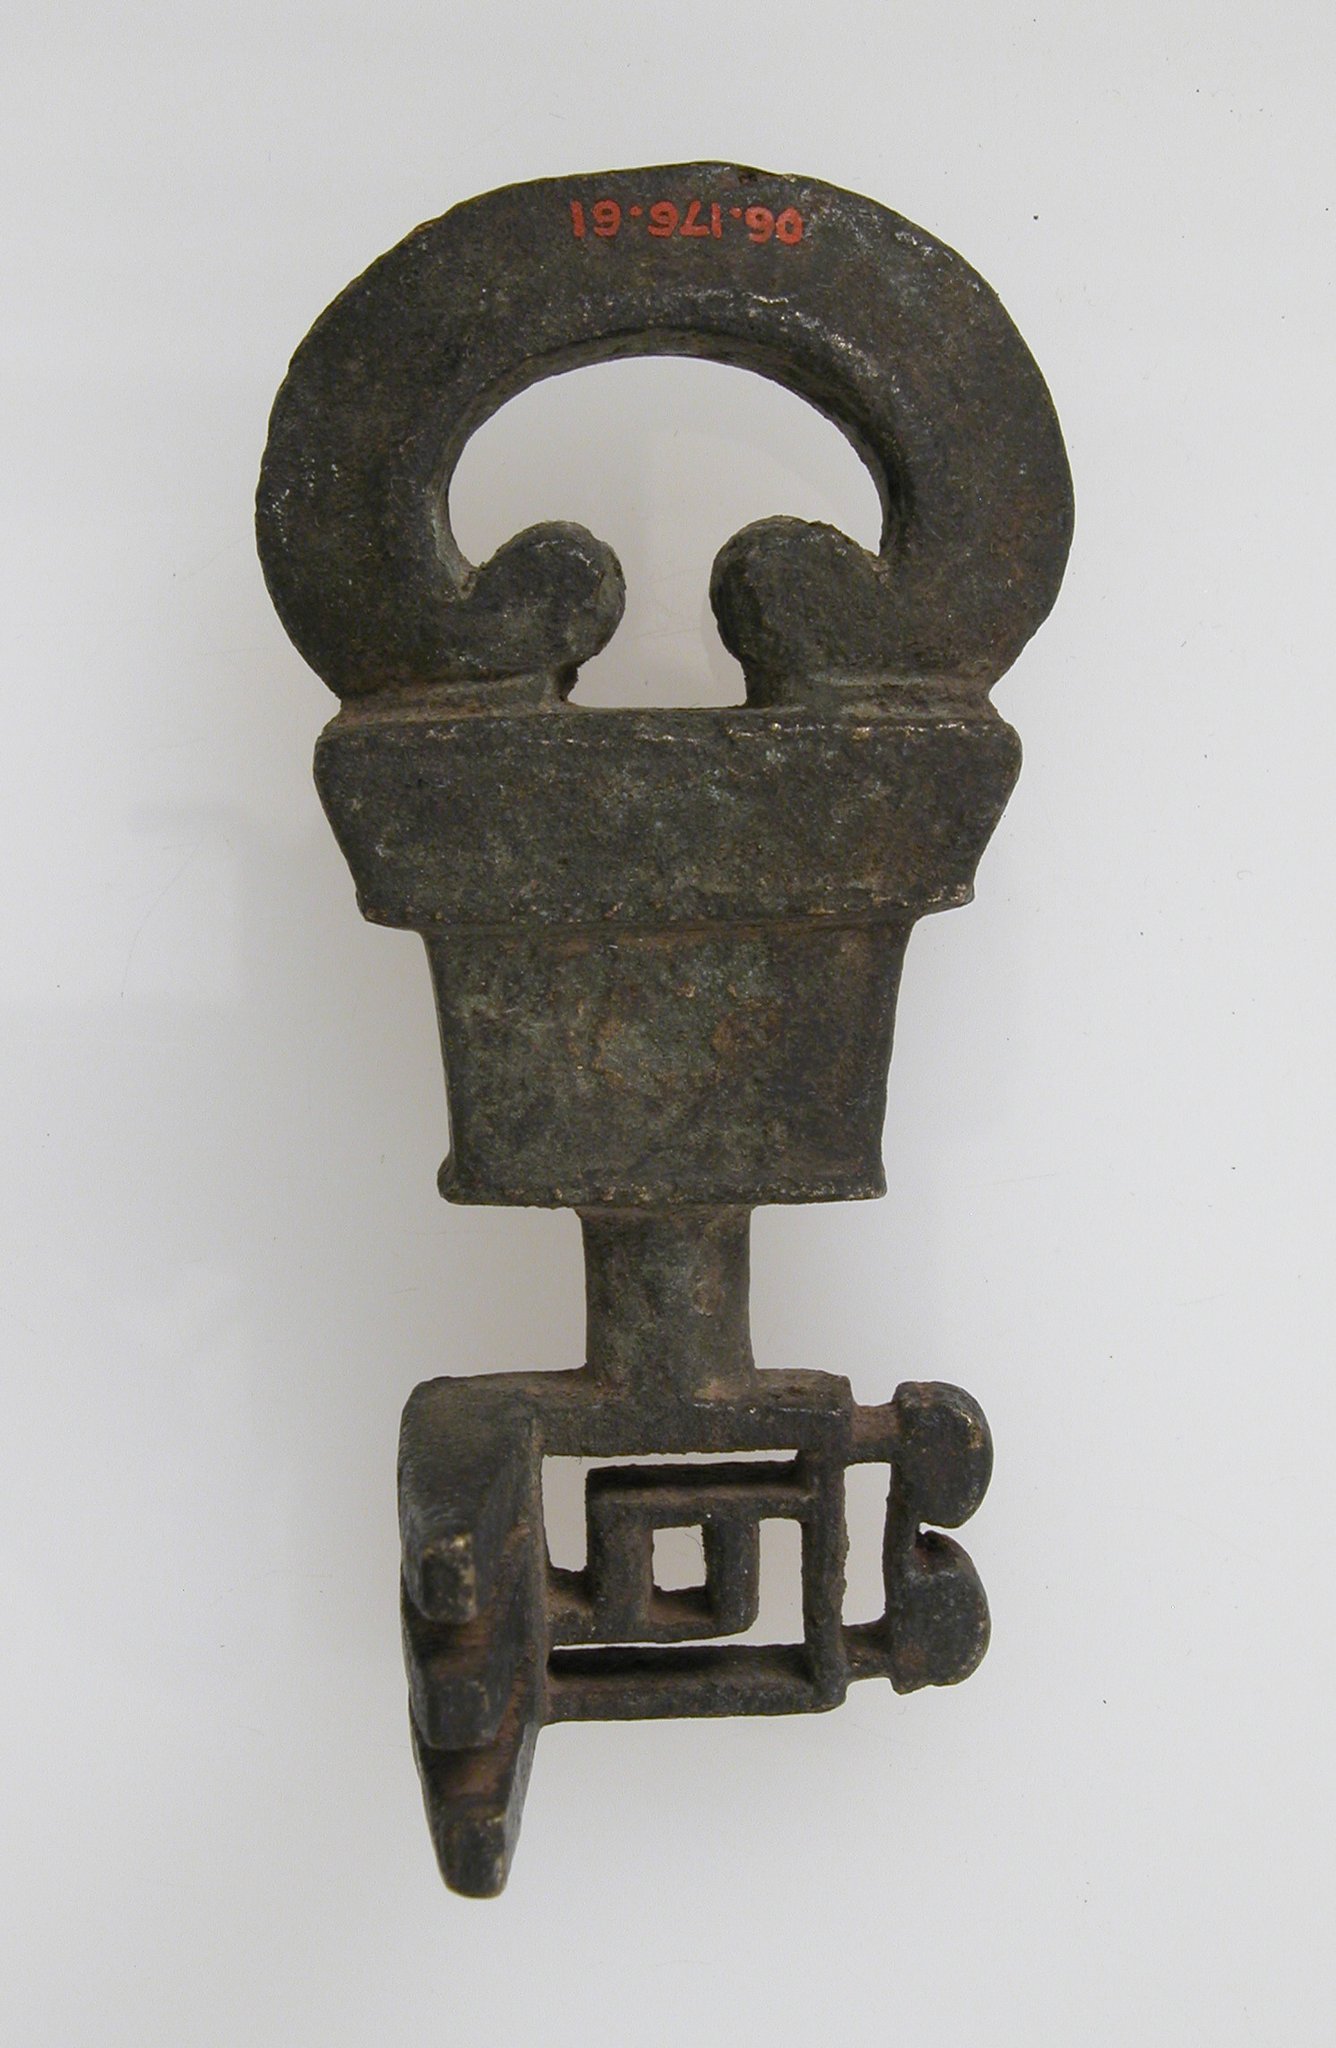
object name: key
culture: roman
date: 1-700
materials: copper alloy